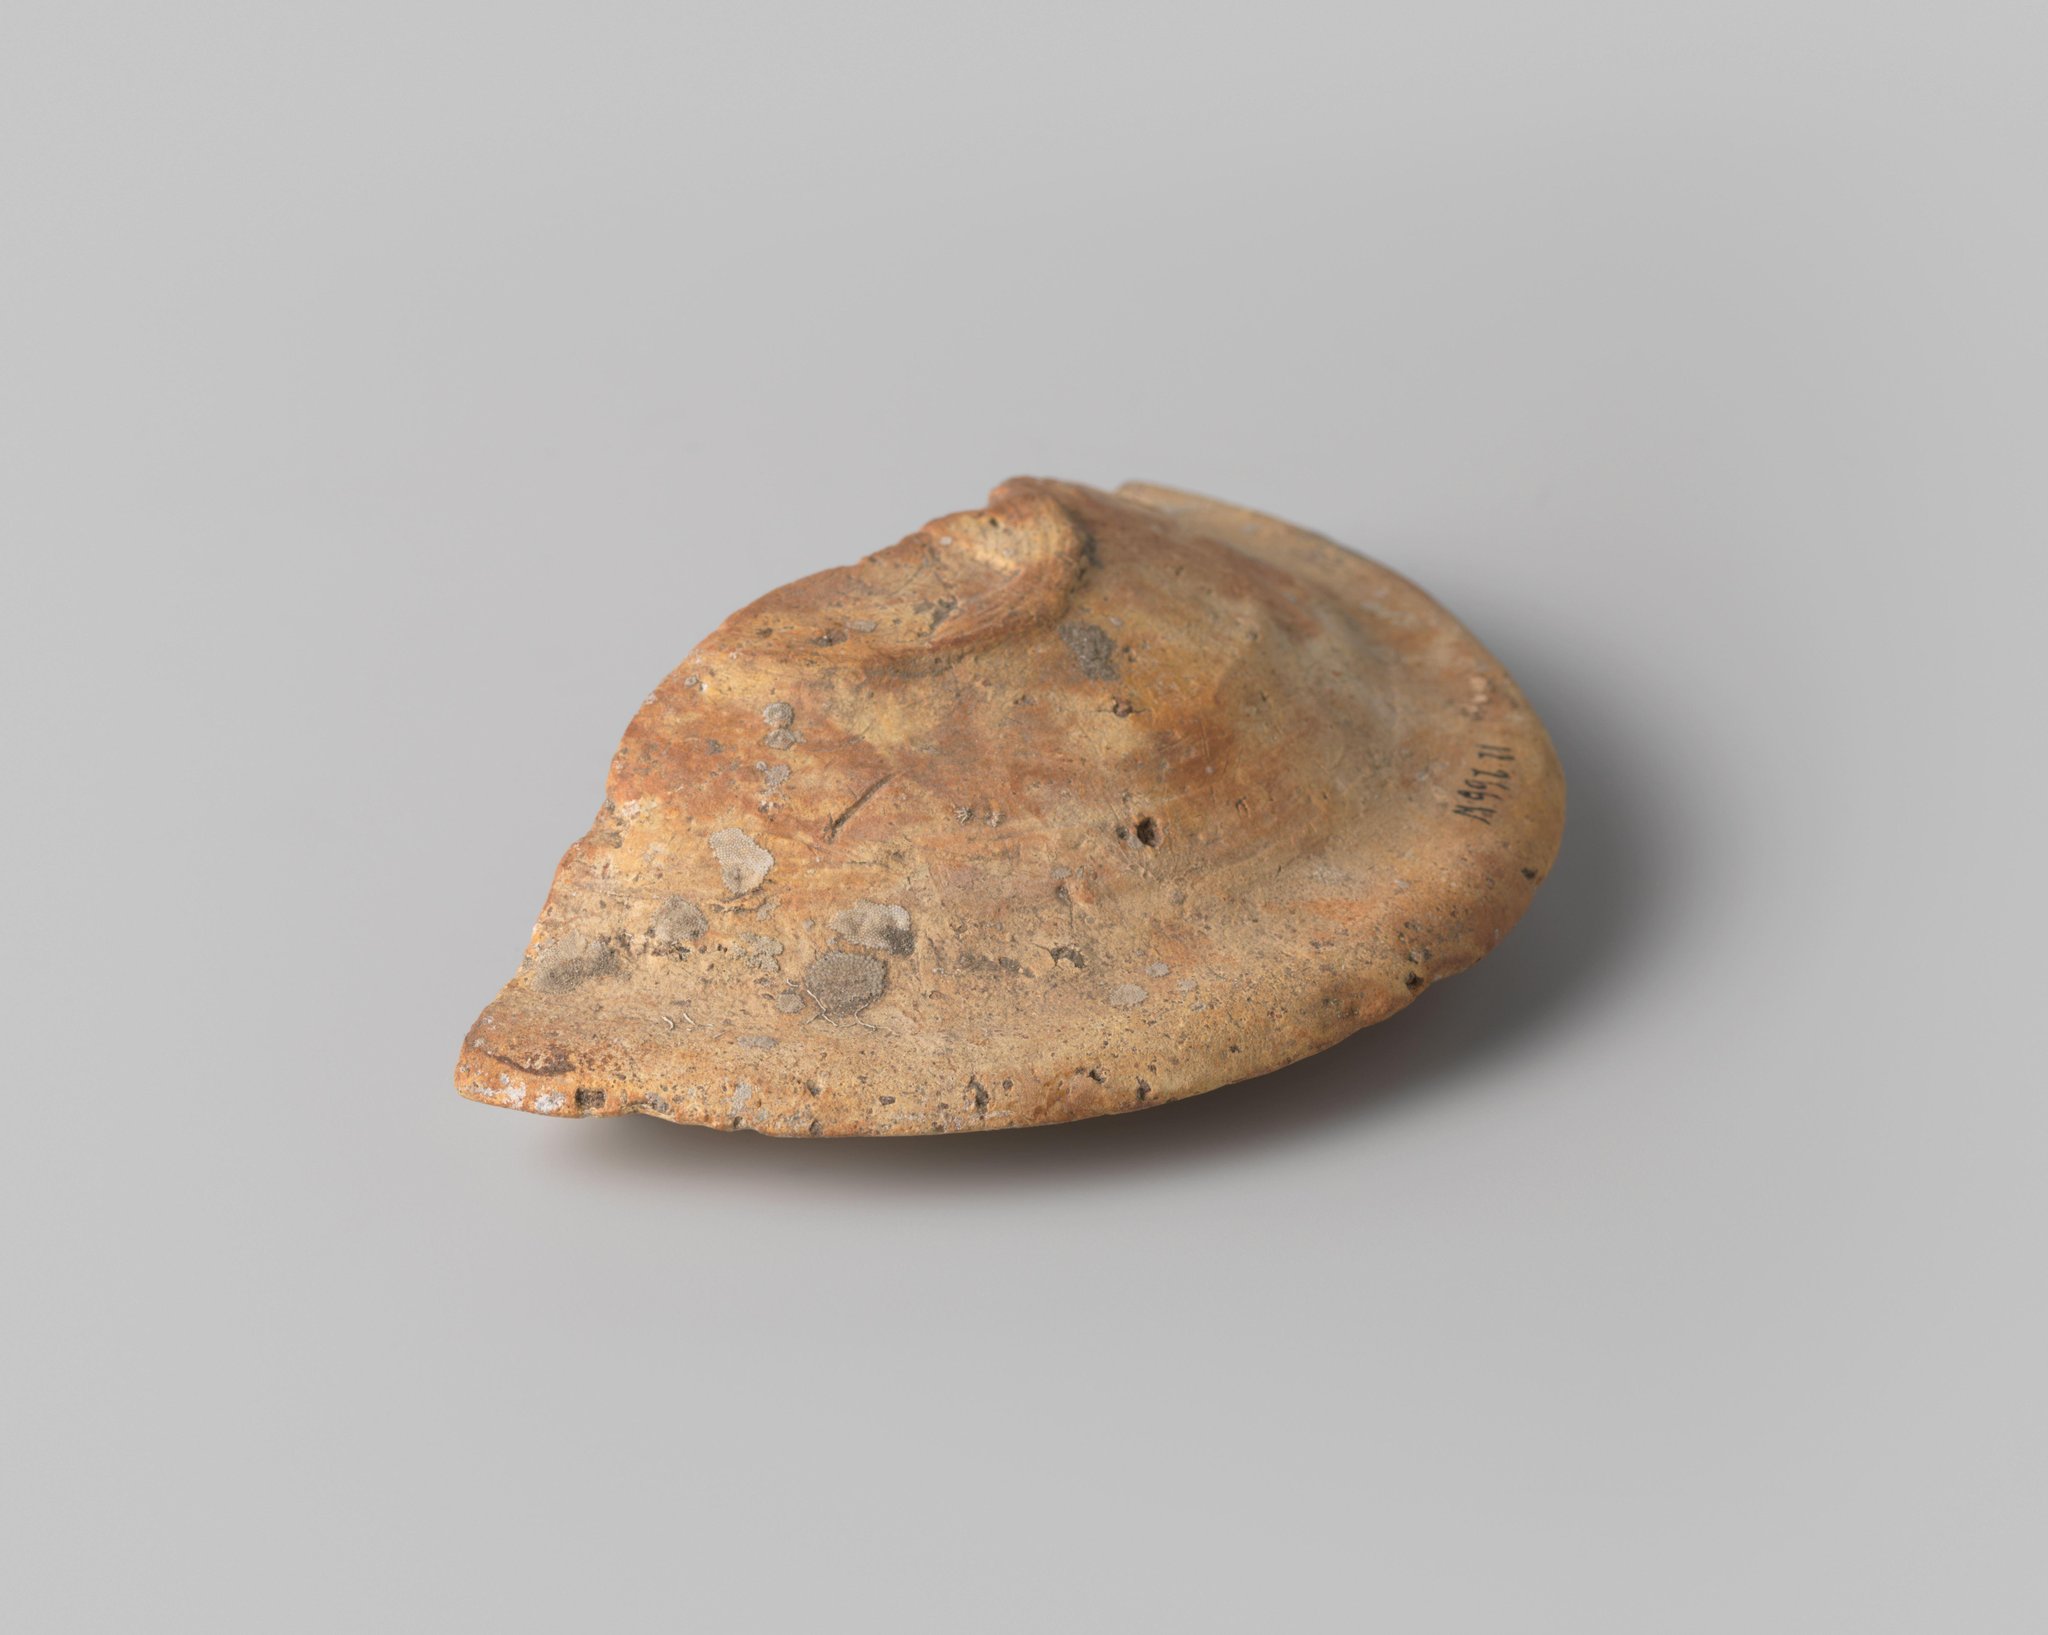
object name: lid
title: Deksel van een martavaan uit V.O.C.-schip de 'Witte Leeuw'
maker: Anonymous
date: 1613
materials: earthenware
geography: southeast asia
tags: verenigde oostindische compagnie, sint-helena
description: An earthenware cover. The round covers have a concave and usually a knob on top. The clay is orange-red, brown, grey or cream-coloured and contains many impurities. The inside of the covers show signs of scratches indicating that a sharp tool has been used to even out the clay. The body is light grey with black and white specks.